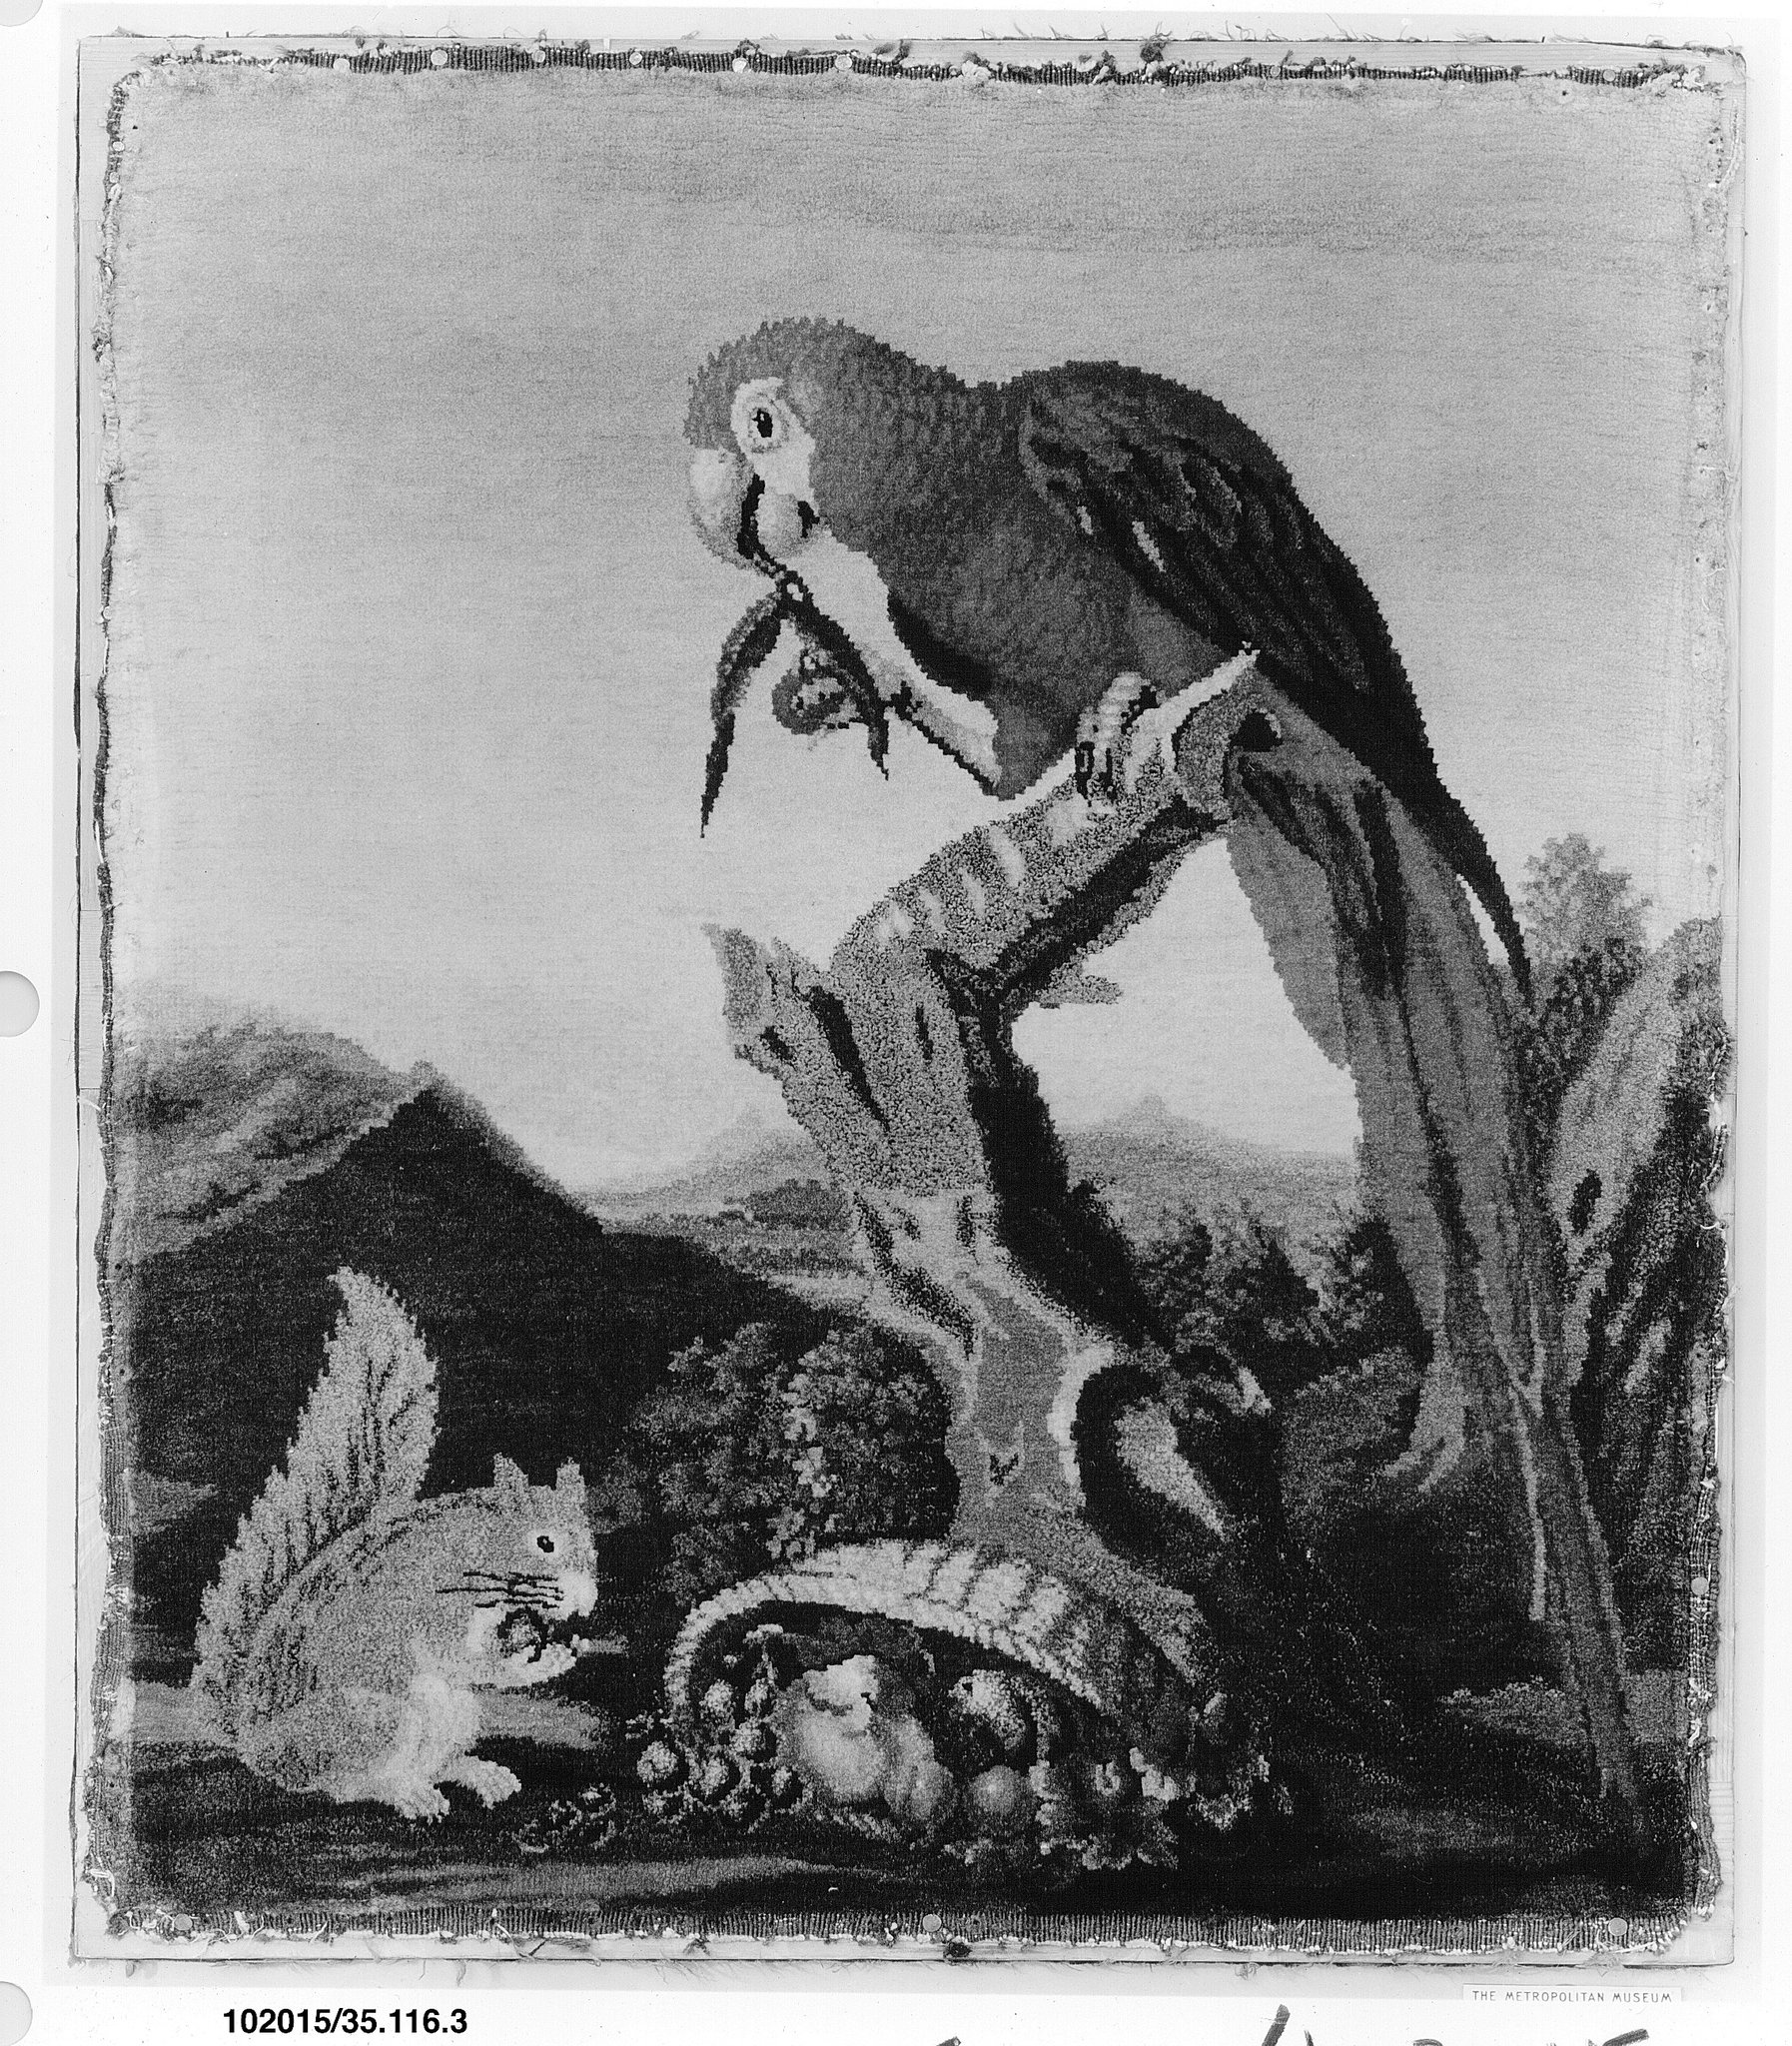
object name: panel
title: Parrot and squirrel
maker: savonnerie manufactory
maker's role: manufactory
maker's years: 1626-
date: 1734-1766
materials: wool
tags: parrots,squirrels